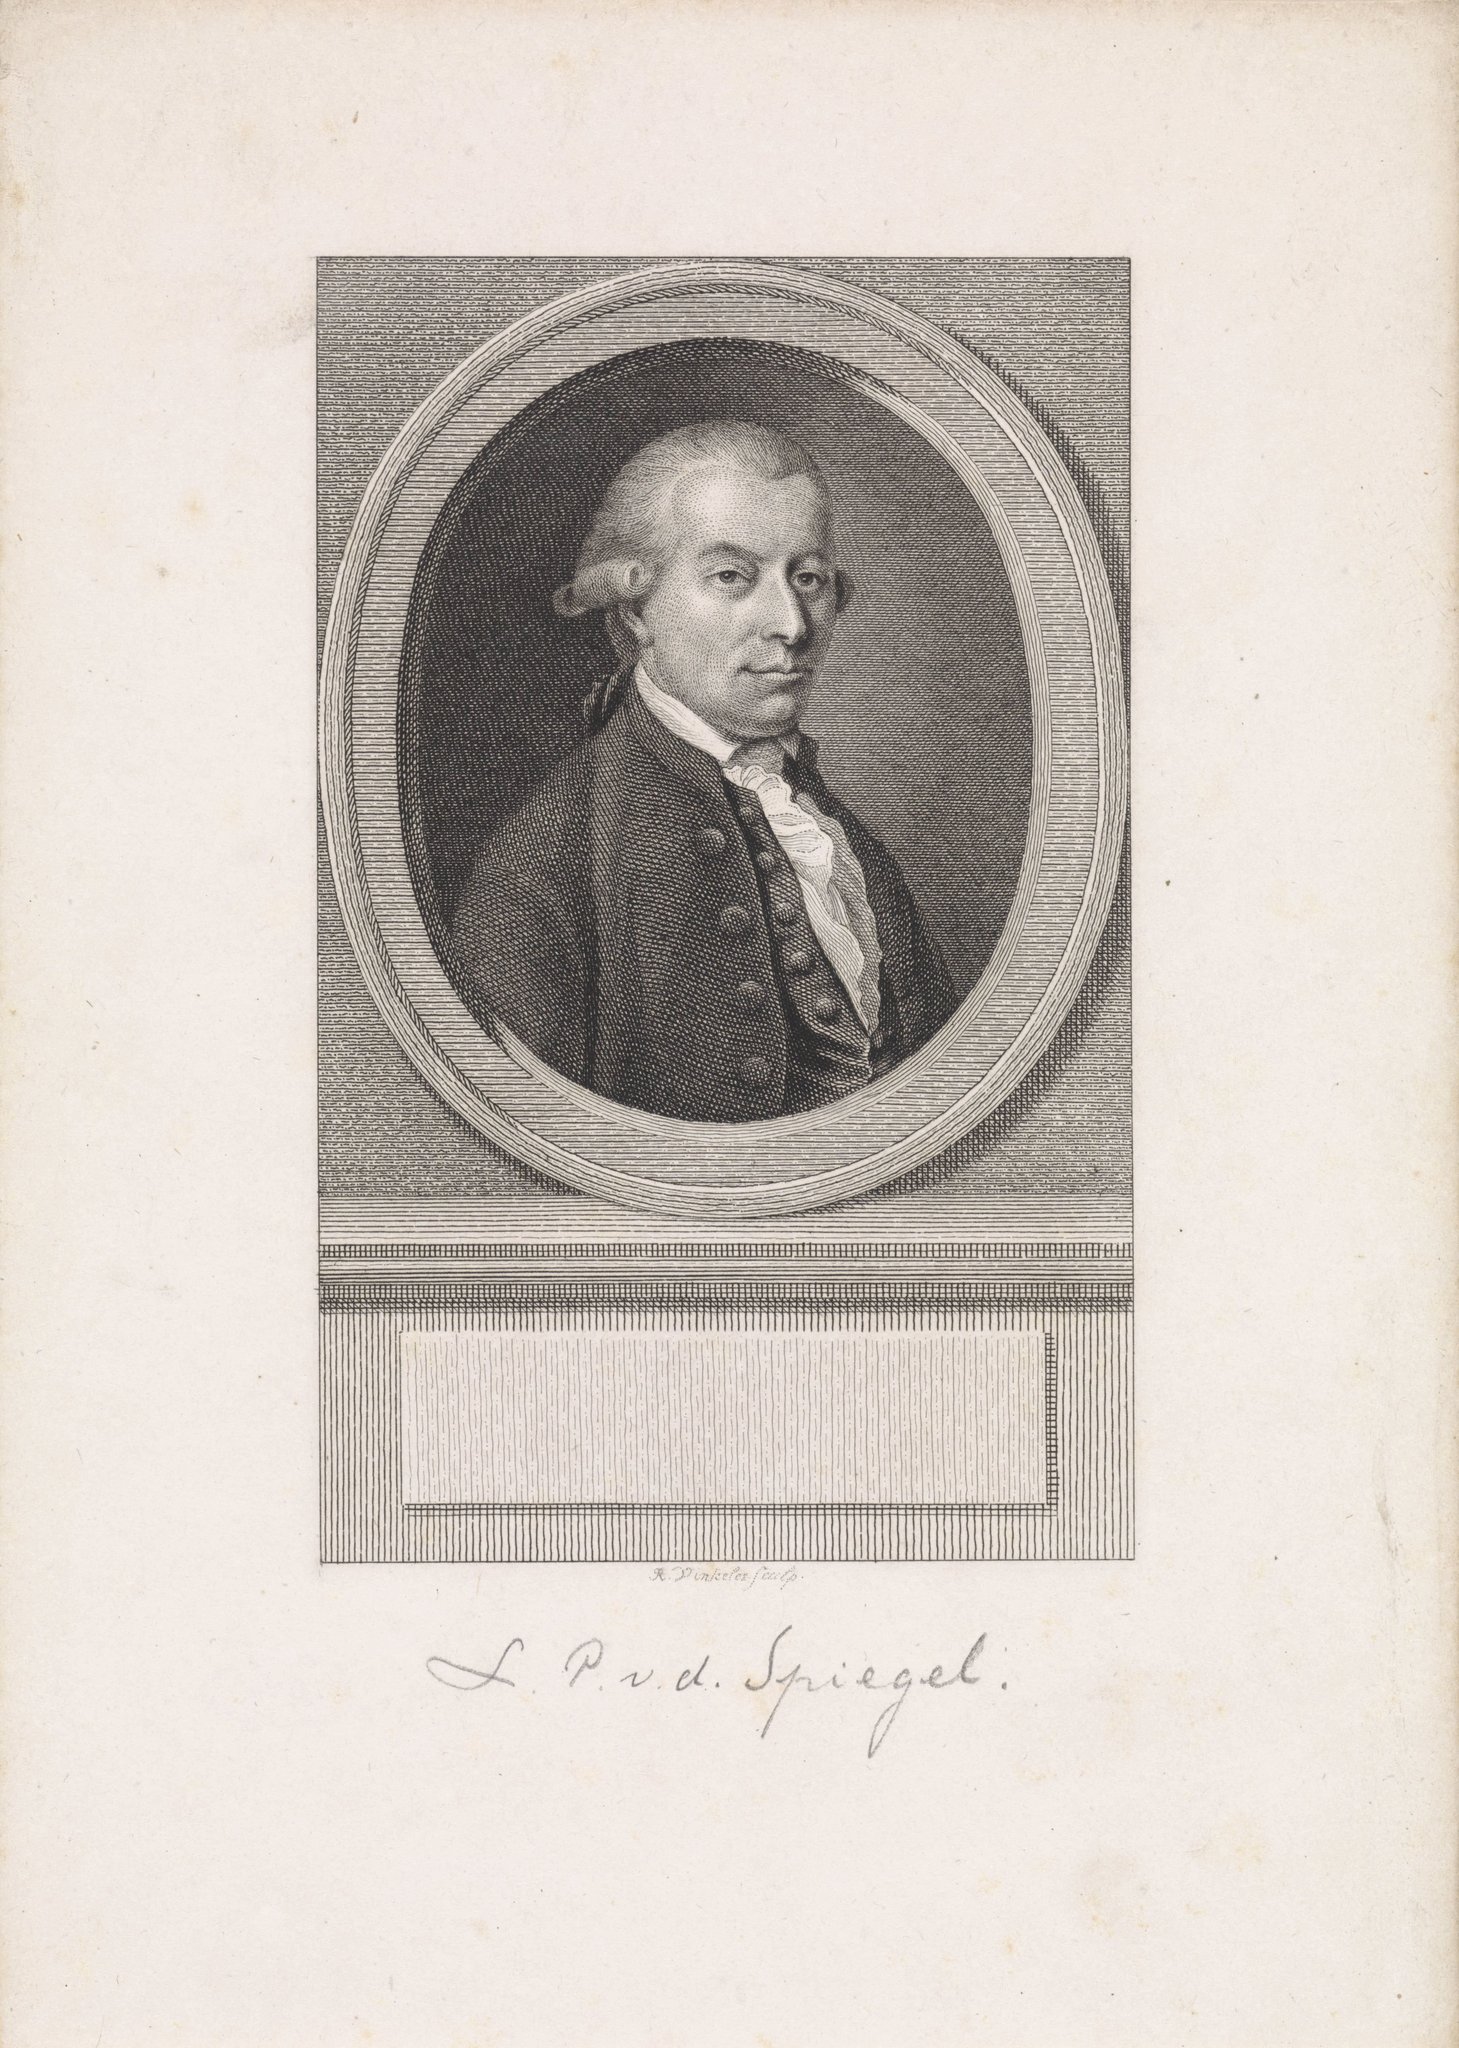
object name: print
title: Portret van Laurens Pieter van de Spiegel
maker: reinier vinkeles (i)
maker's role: draughtsman, print maker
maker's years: 1741-1816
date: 1786-1809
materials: paper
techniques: engraving, etching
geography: amsterdam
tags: laurens pieter van de spiegel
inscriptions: collector's mark: Lugt 2228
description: Latere staat prent ook gebruikt als boekillustratie in: Wagenaar, Jan. Vaderlandsche historie, (...) ten vervolge van Wagenaars Vaderlandsche historie. Dl. 1-43. Amsterdam: Johannes Allart, 1786-1809.